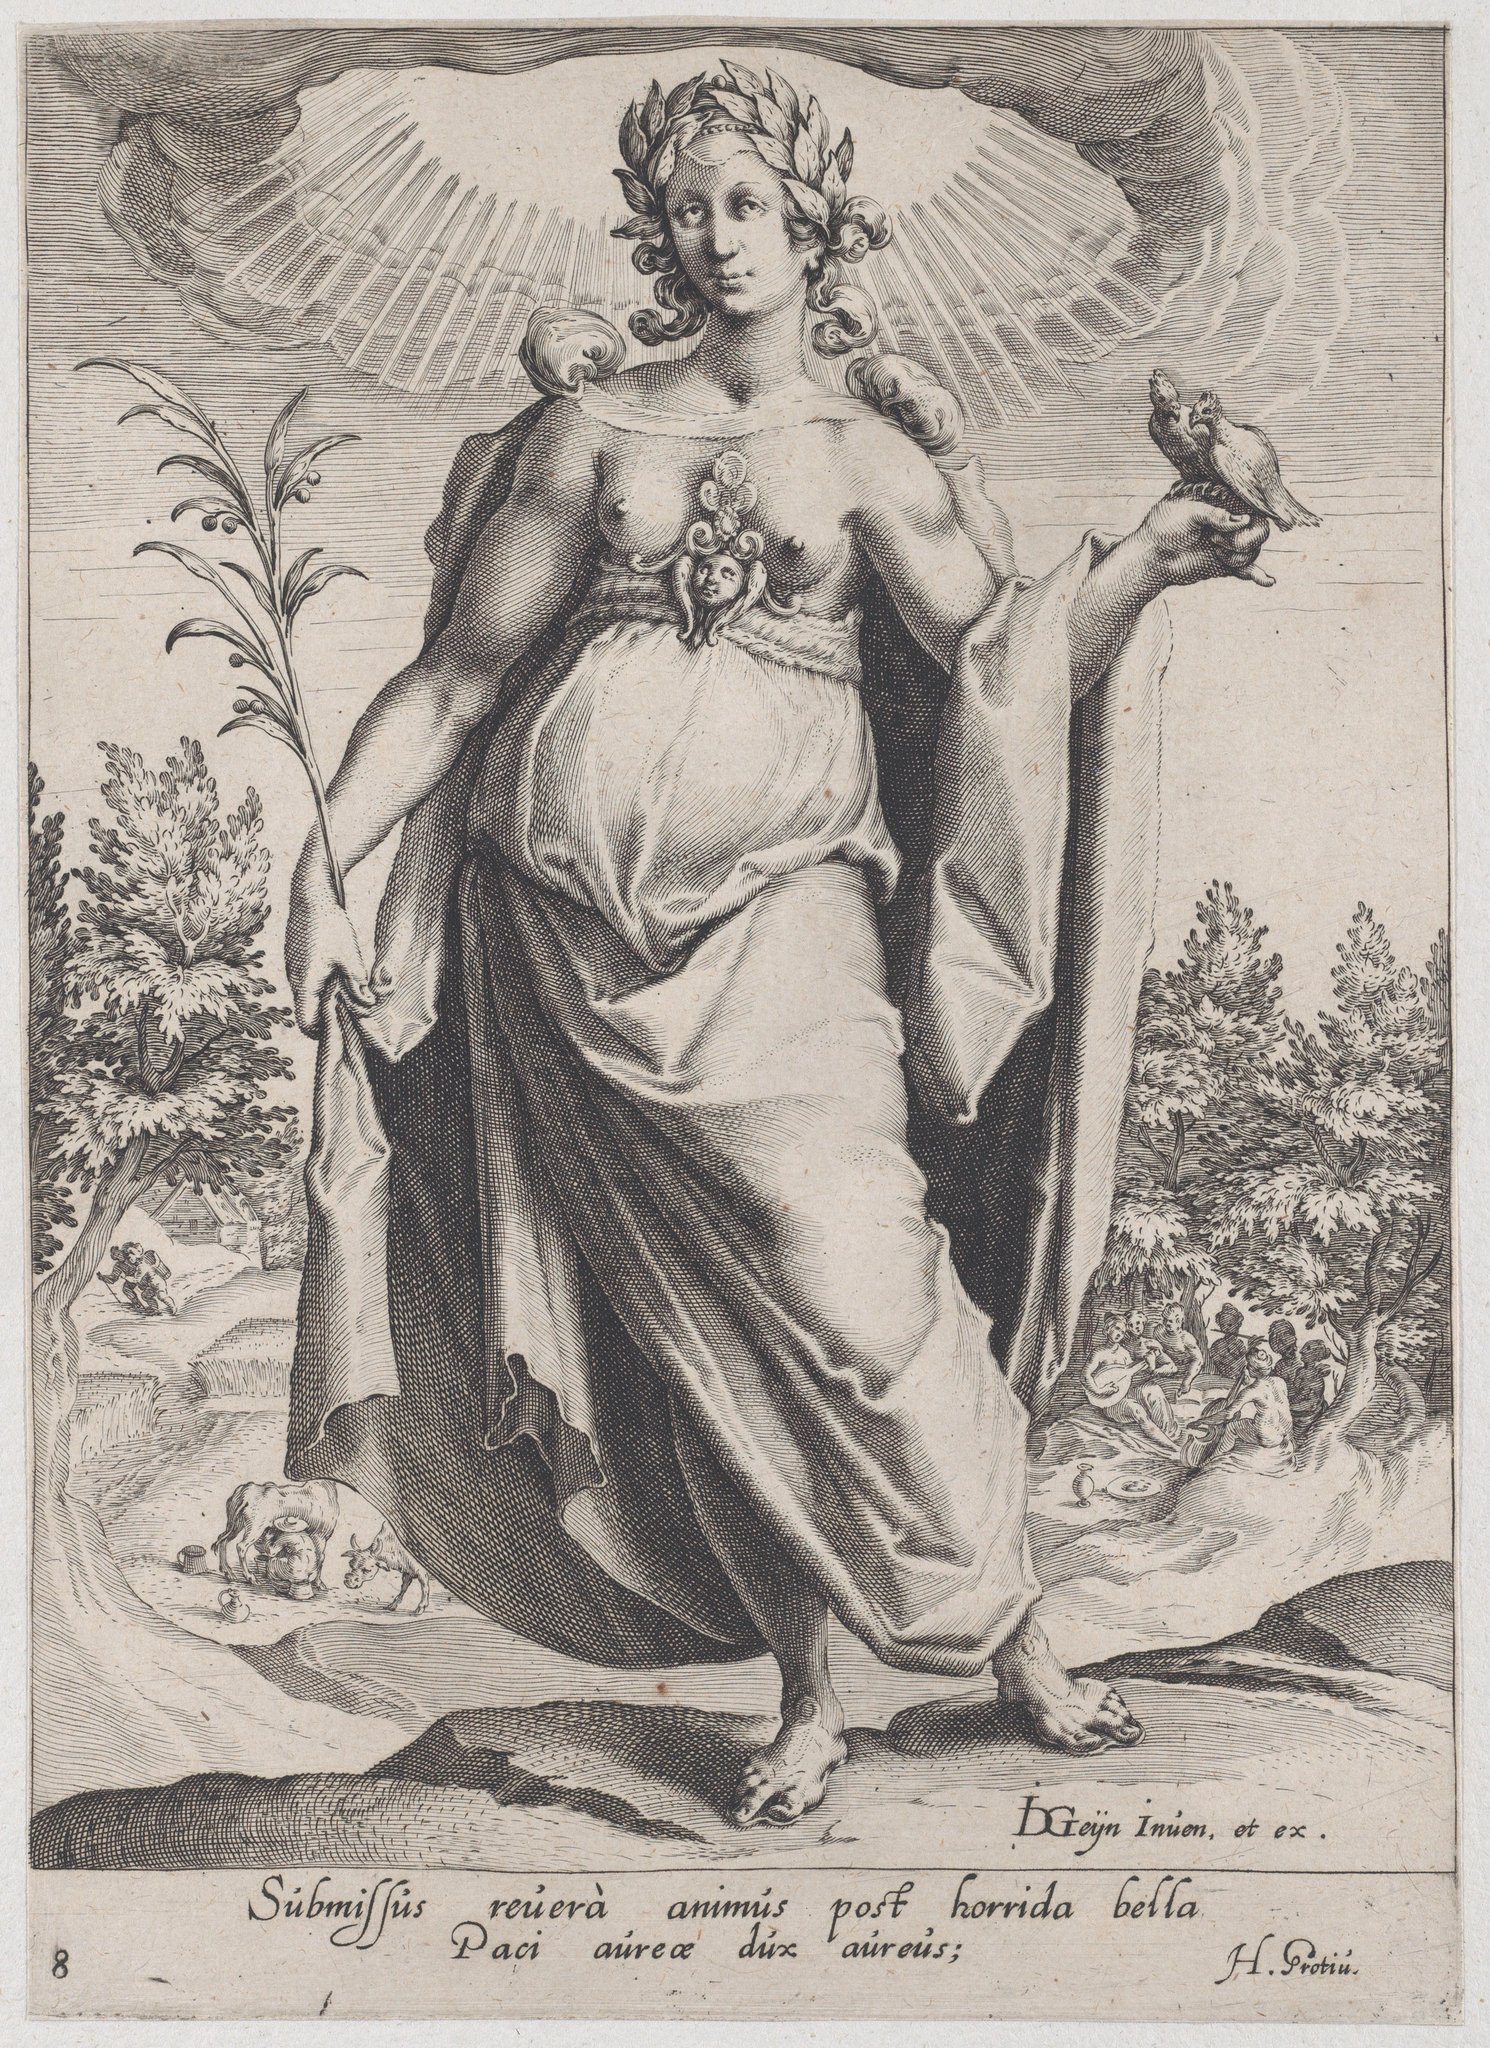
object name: print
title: Peace, from "Virtues and Vices"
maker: zacharias dolendo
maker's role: artist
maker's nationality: netherlandish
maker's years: 1561-1604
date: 1596-1597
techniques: engraving